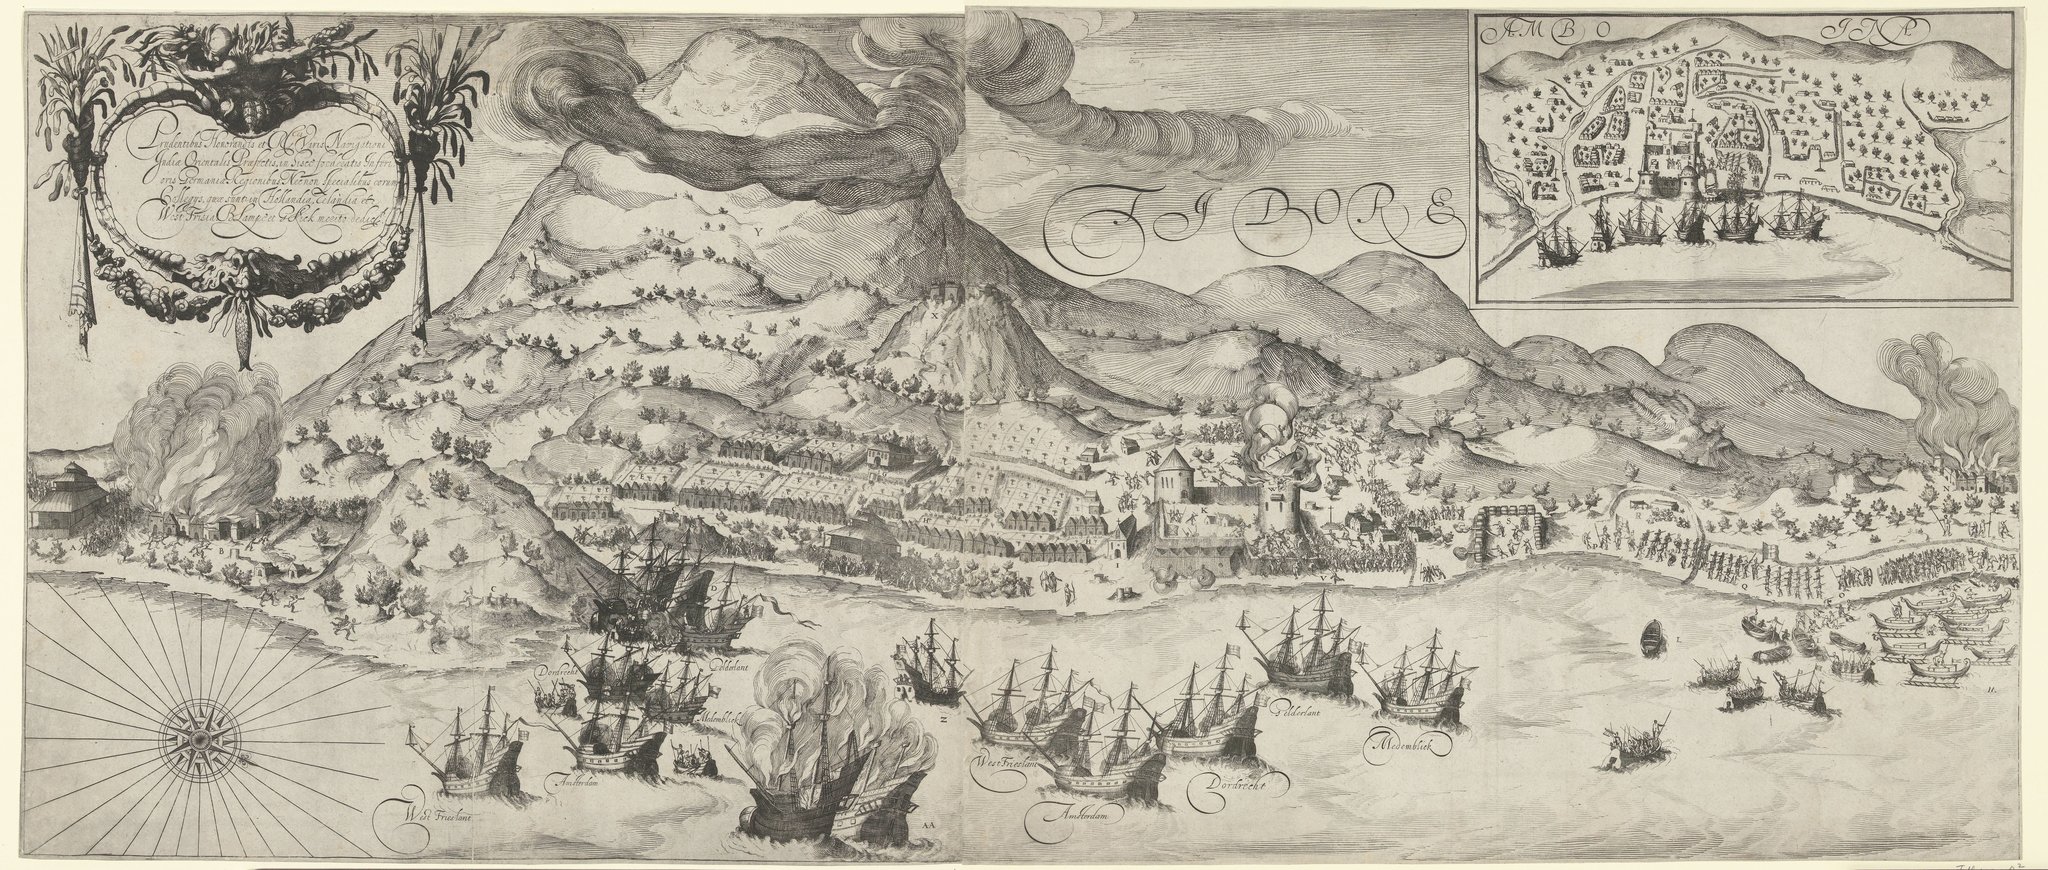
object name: print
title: Overwinning van de Hollanders op de Portugezen op Tidore, 1605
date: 1606-1610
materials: paper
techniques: engraving, etching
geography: northern netherlands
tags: battle (+ naval force), battle (+ land forces)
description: Overwinning van de Hollandse schepen onder bevel van vice-admiraal Cornelis Bastiaansz. van de vloot van Steven van der Hagen op de Portugezen, 19 mei 1605. Grote voorstelling in twee platen. Links de schepen in gevecht voor de kust van Tidore. Een dorp gaat in vlammen op. Linksbovenaan een cartouche versierd met festoenen met de opdracht in het Latijn. Rechts de aankomst van de vijf Hollandse schepen bij Tidore, rechts de bootjes van de lokale bevolking. Aan land gaat het fort in vlammen op. Rechtsboven een inzet met een kaart van Ambon. De bijbehorende legenda ontbreekt.